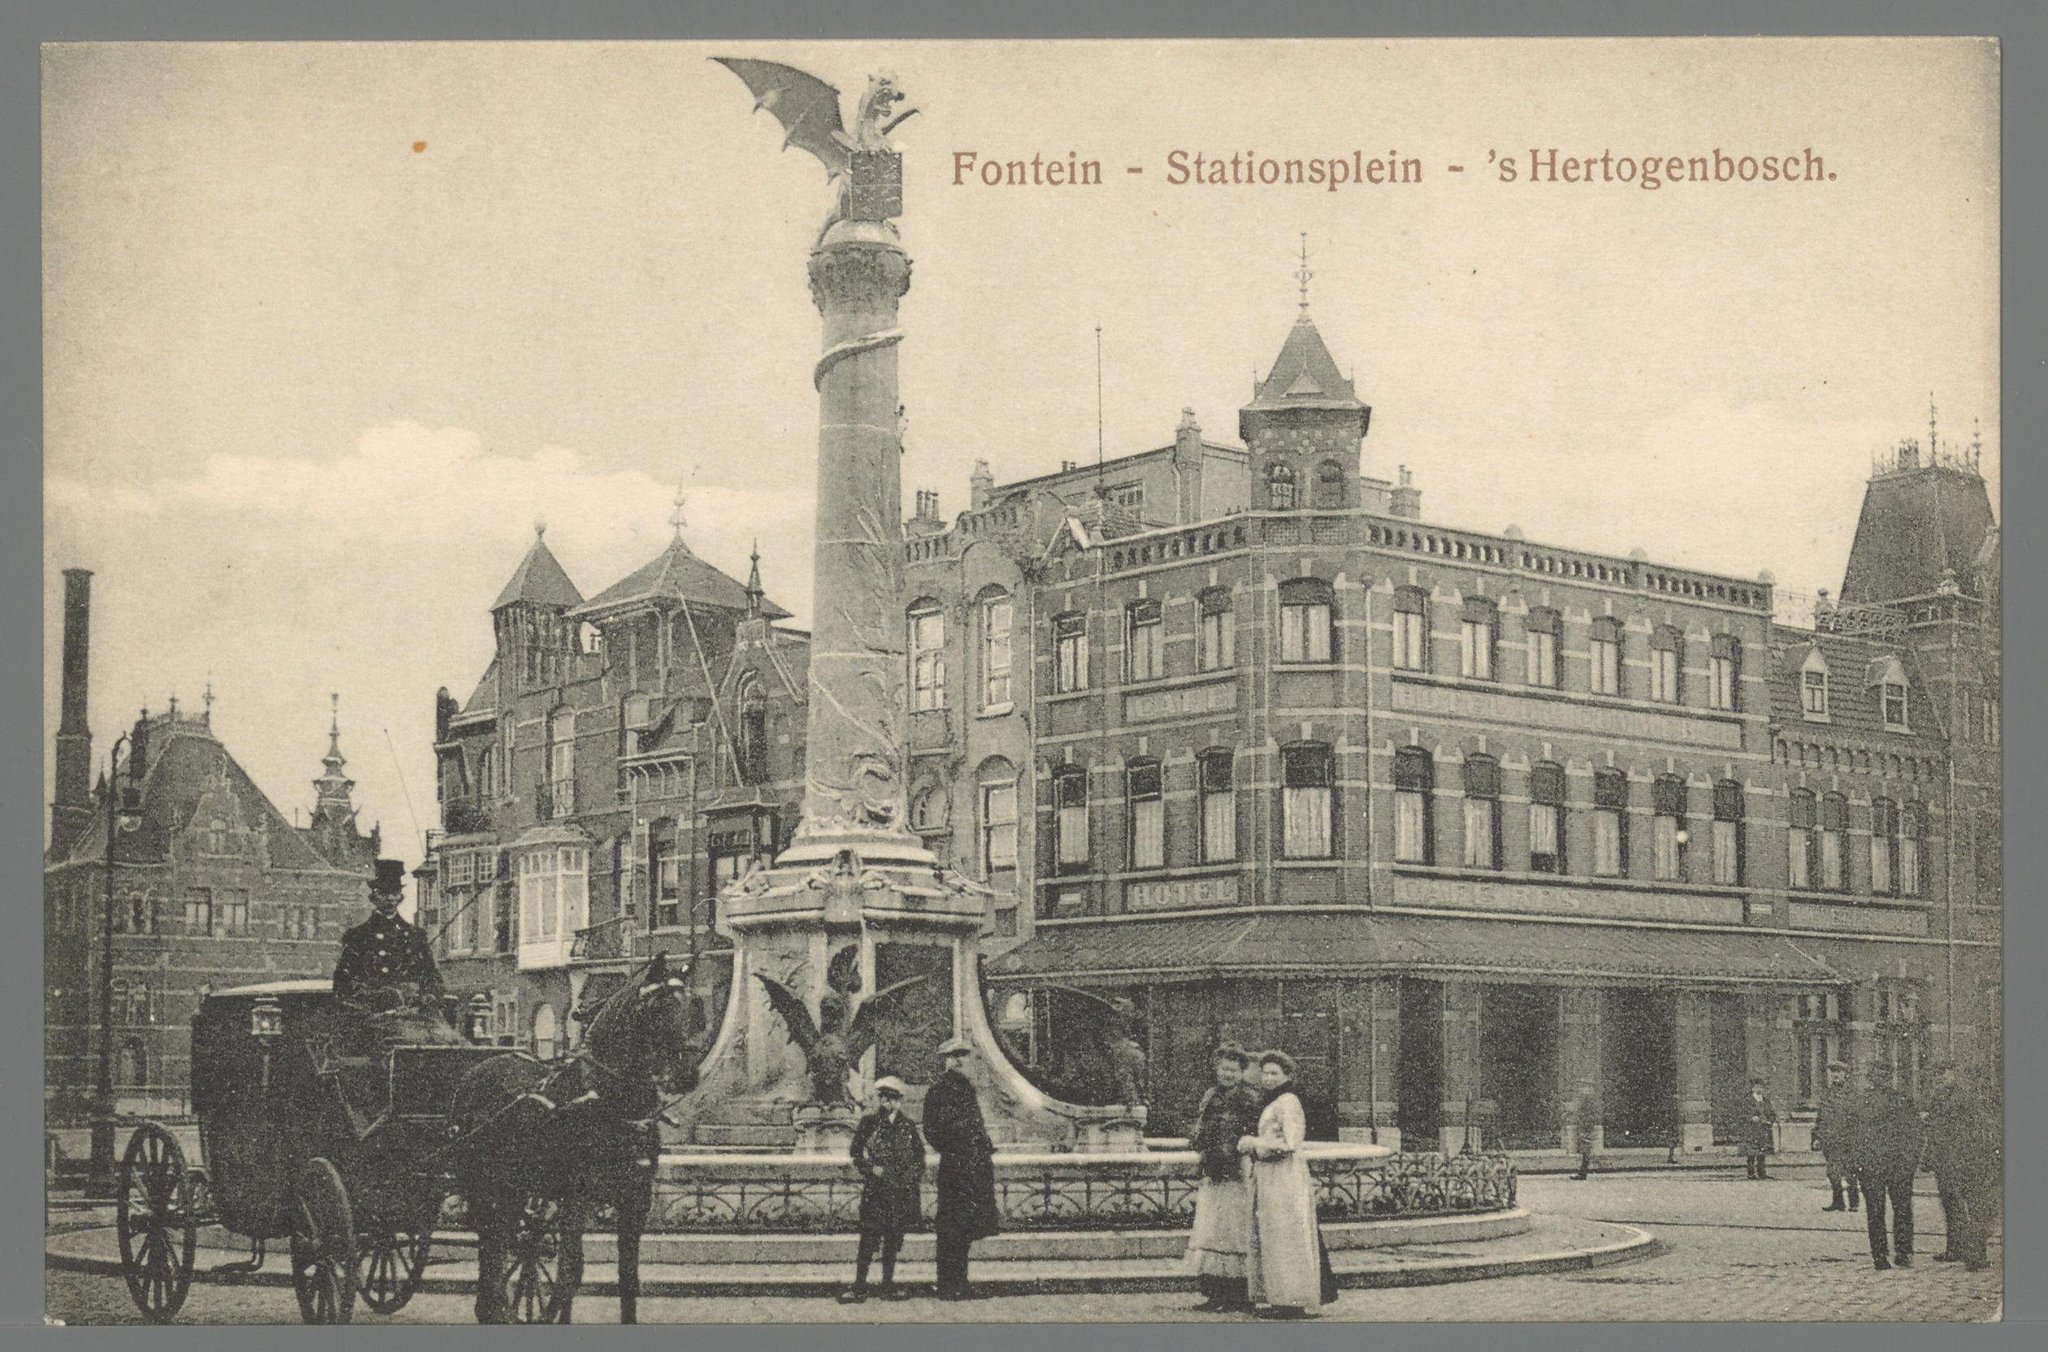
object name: photomechanical print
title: Fontein - Stationsplein - 's Hertogenbosch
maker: Anonymous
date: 1912-1930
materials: cardboard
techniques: photograph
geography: den bosch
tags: four-wheeled vehicle drawn by one animal, ornamental fountain